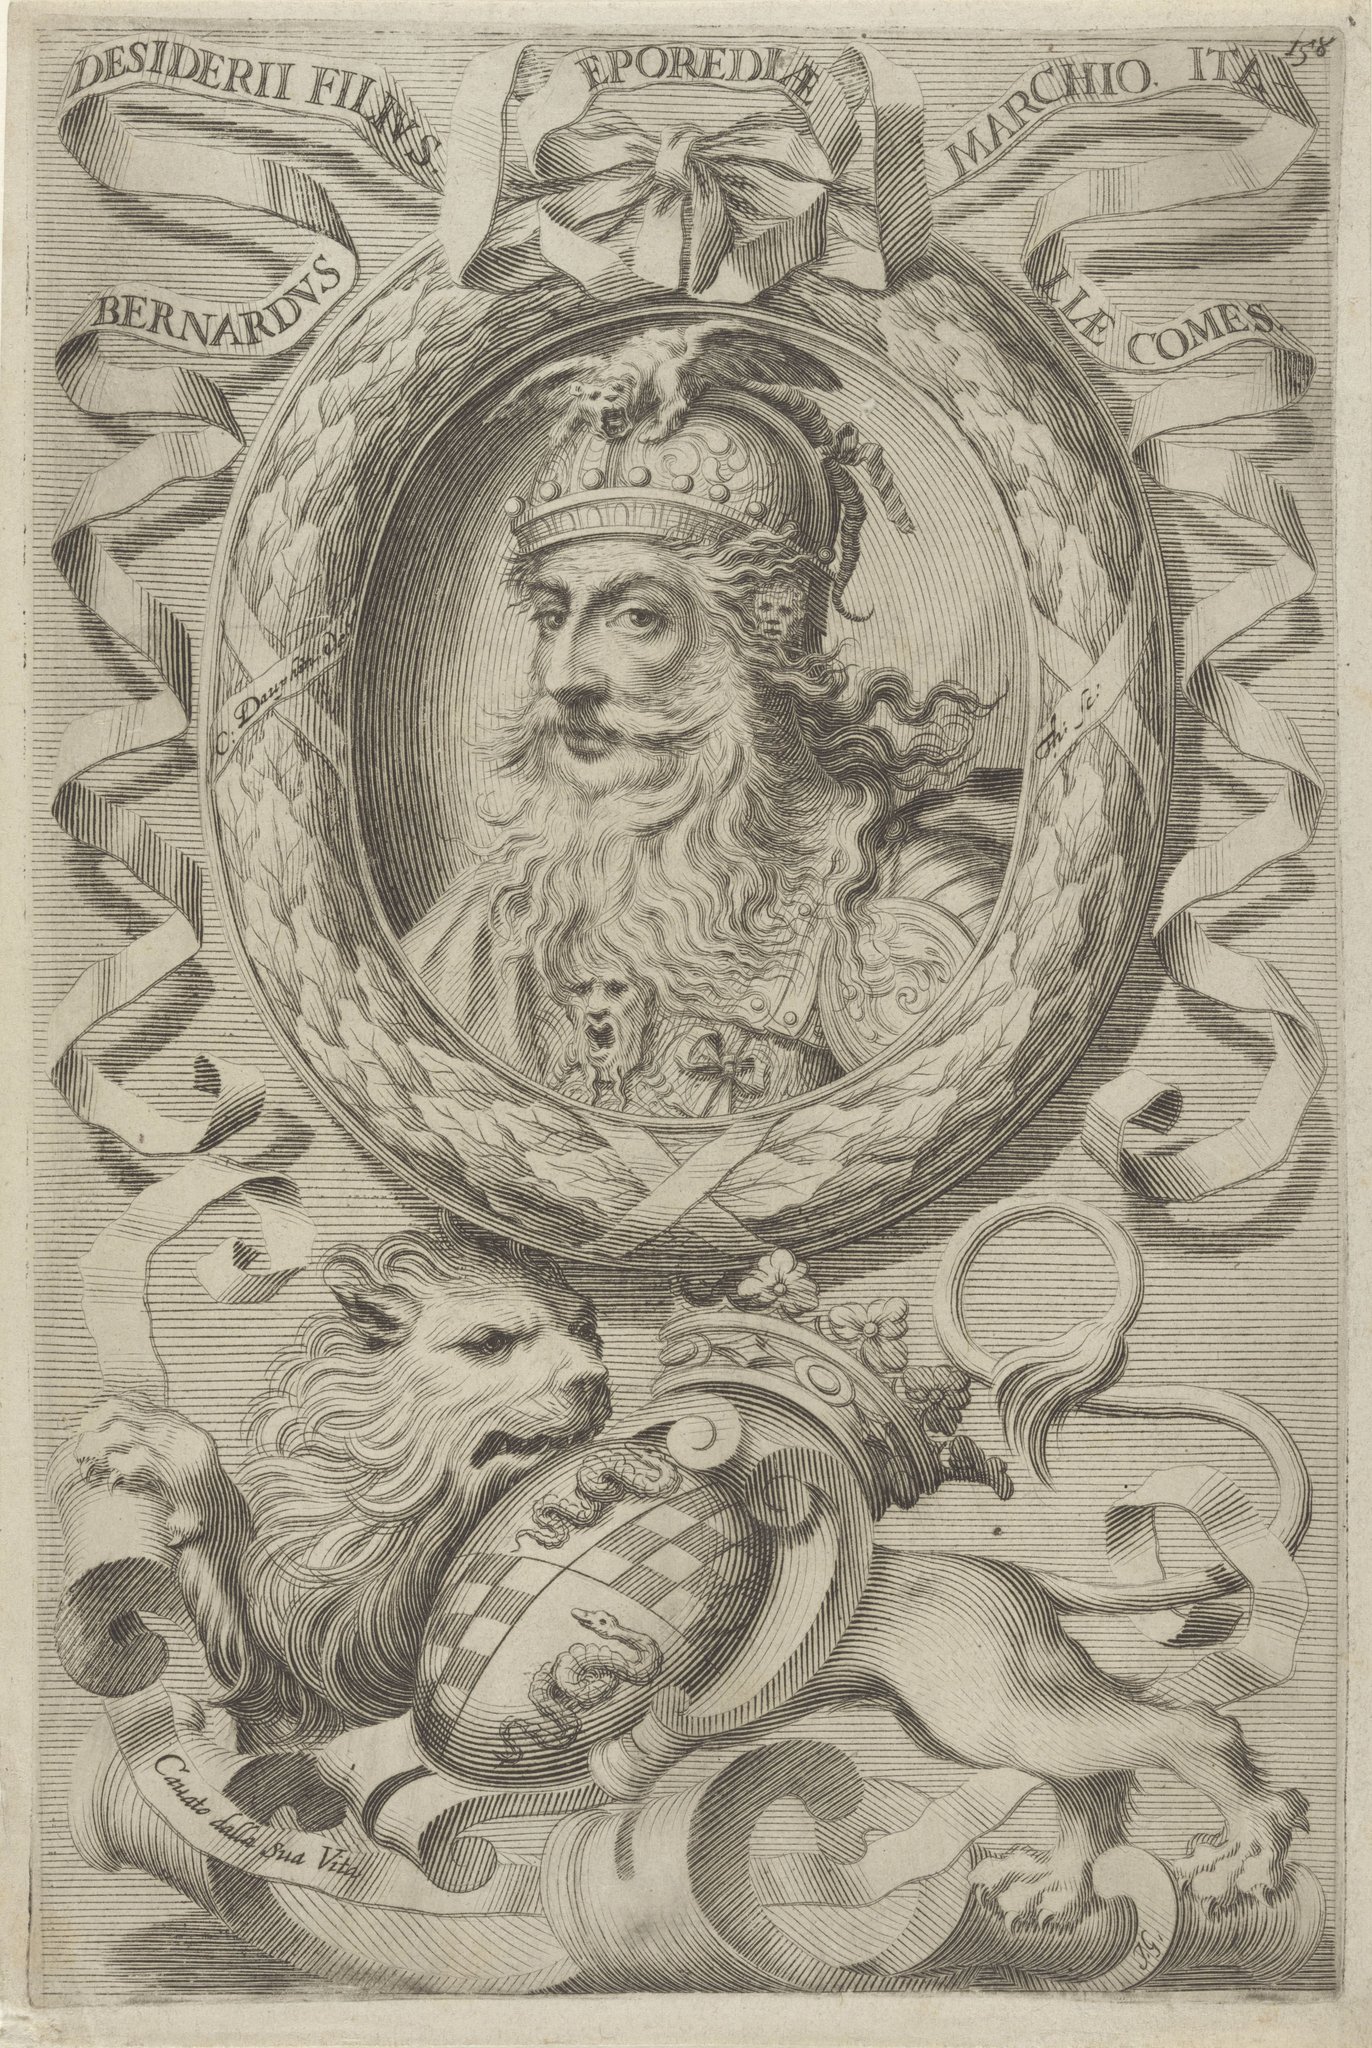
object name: print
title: Bernardus Desiderii filius Eporediae marchio Italiae comes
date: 1650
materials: paper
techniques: engraving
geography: italy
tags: coat of arms (symbol of sovereignty), historical persons, beasts of prey, predatory animals: lion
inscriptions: collector's mark: Lugt 2228